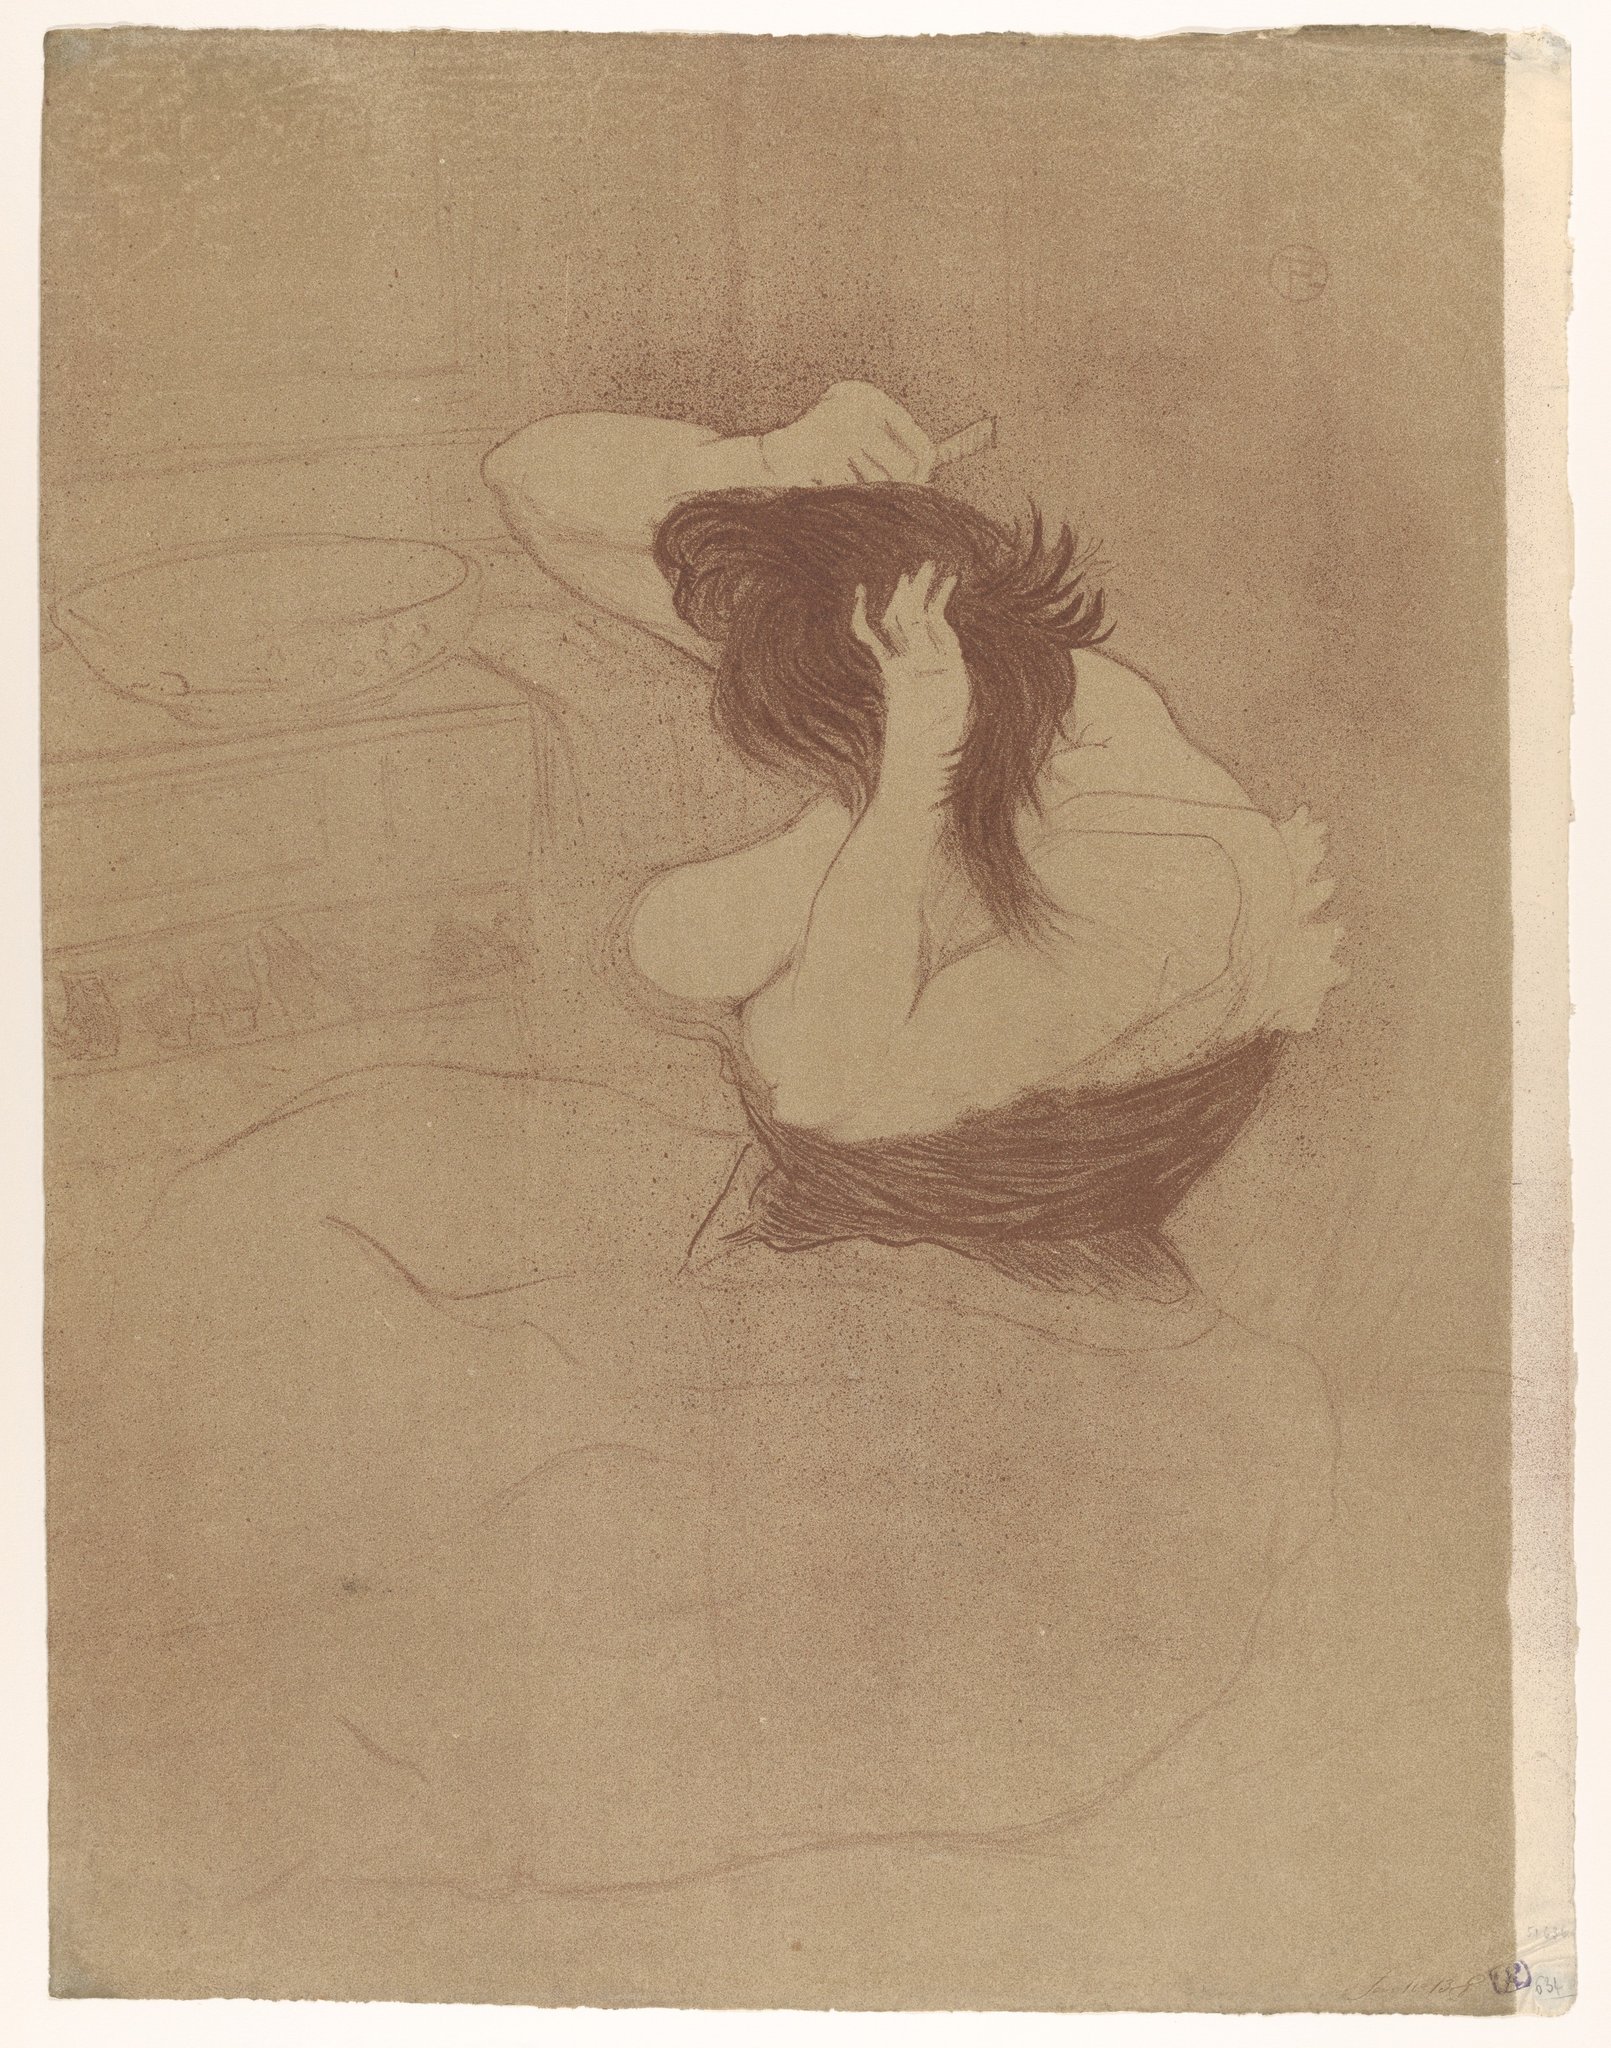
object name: print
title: Combing Their Hair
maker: henri de toulouse-lautrec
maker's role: artist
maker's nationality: french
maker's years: 1864-1901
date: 1896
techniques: lithograph, printing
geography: france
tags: hair,women